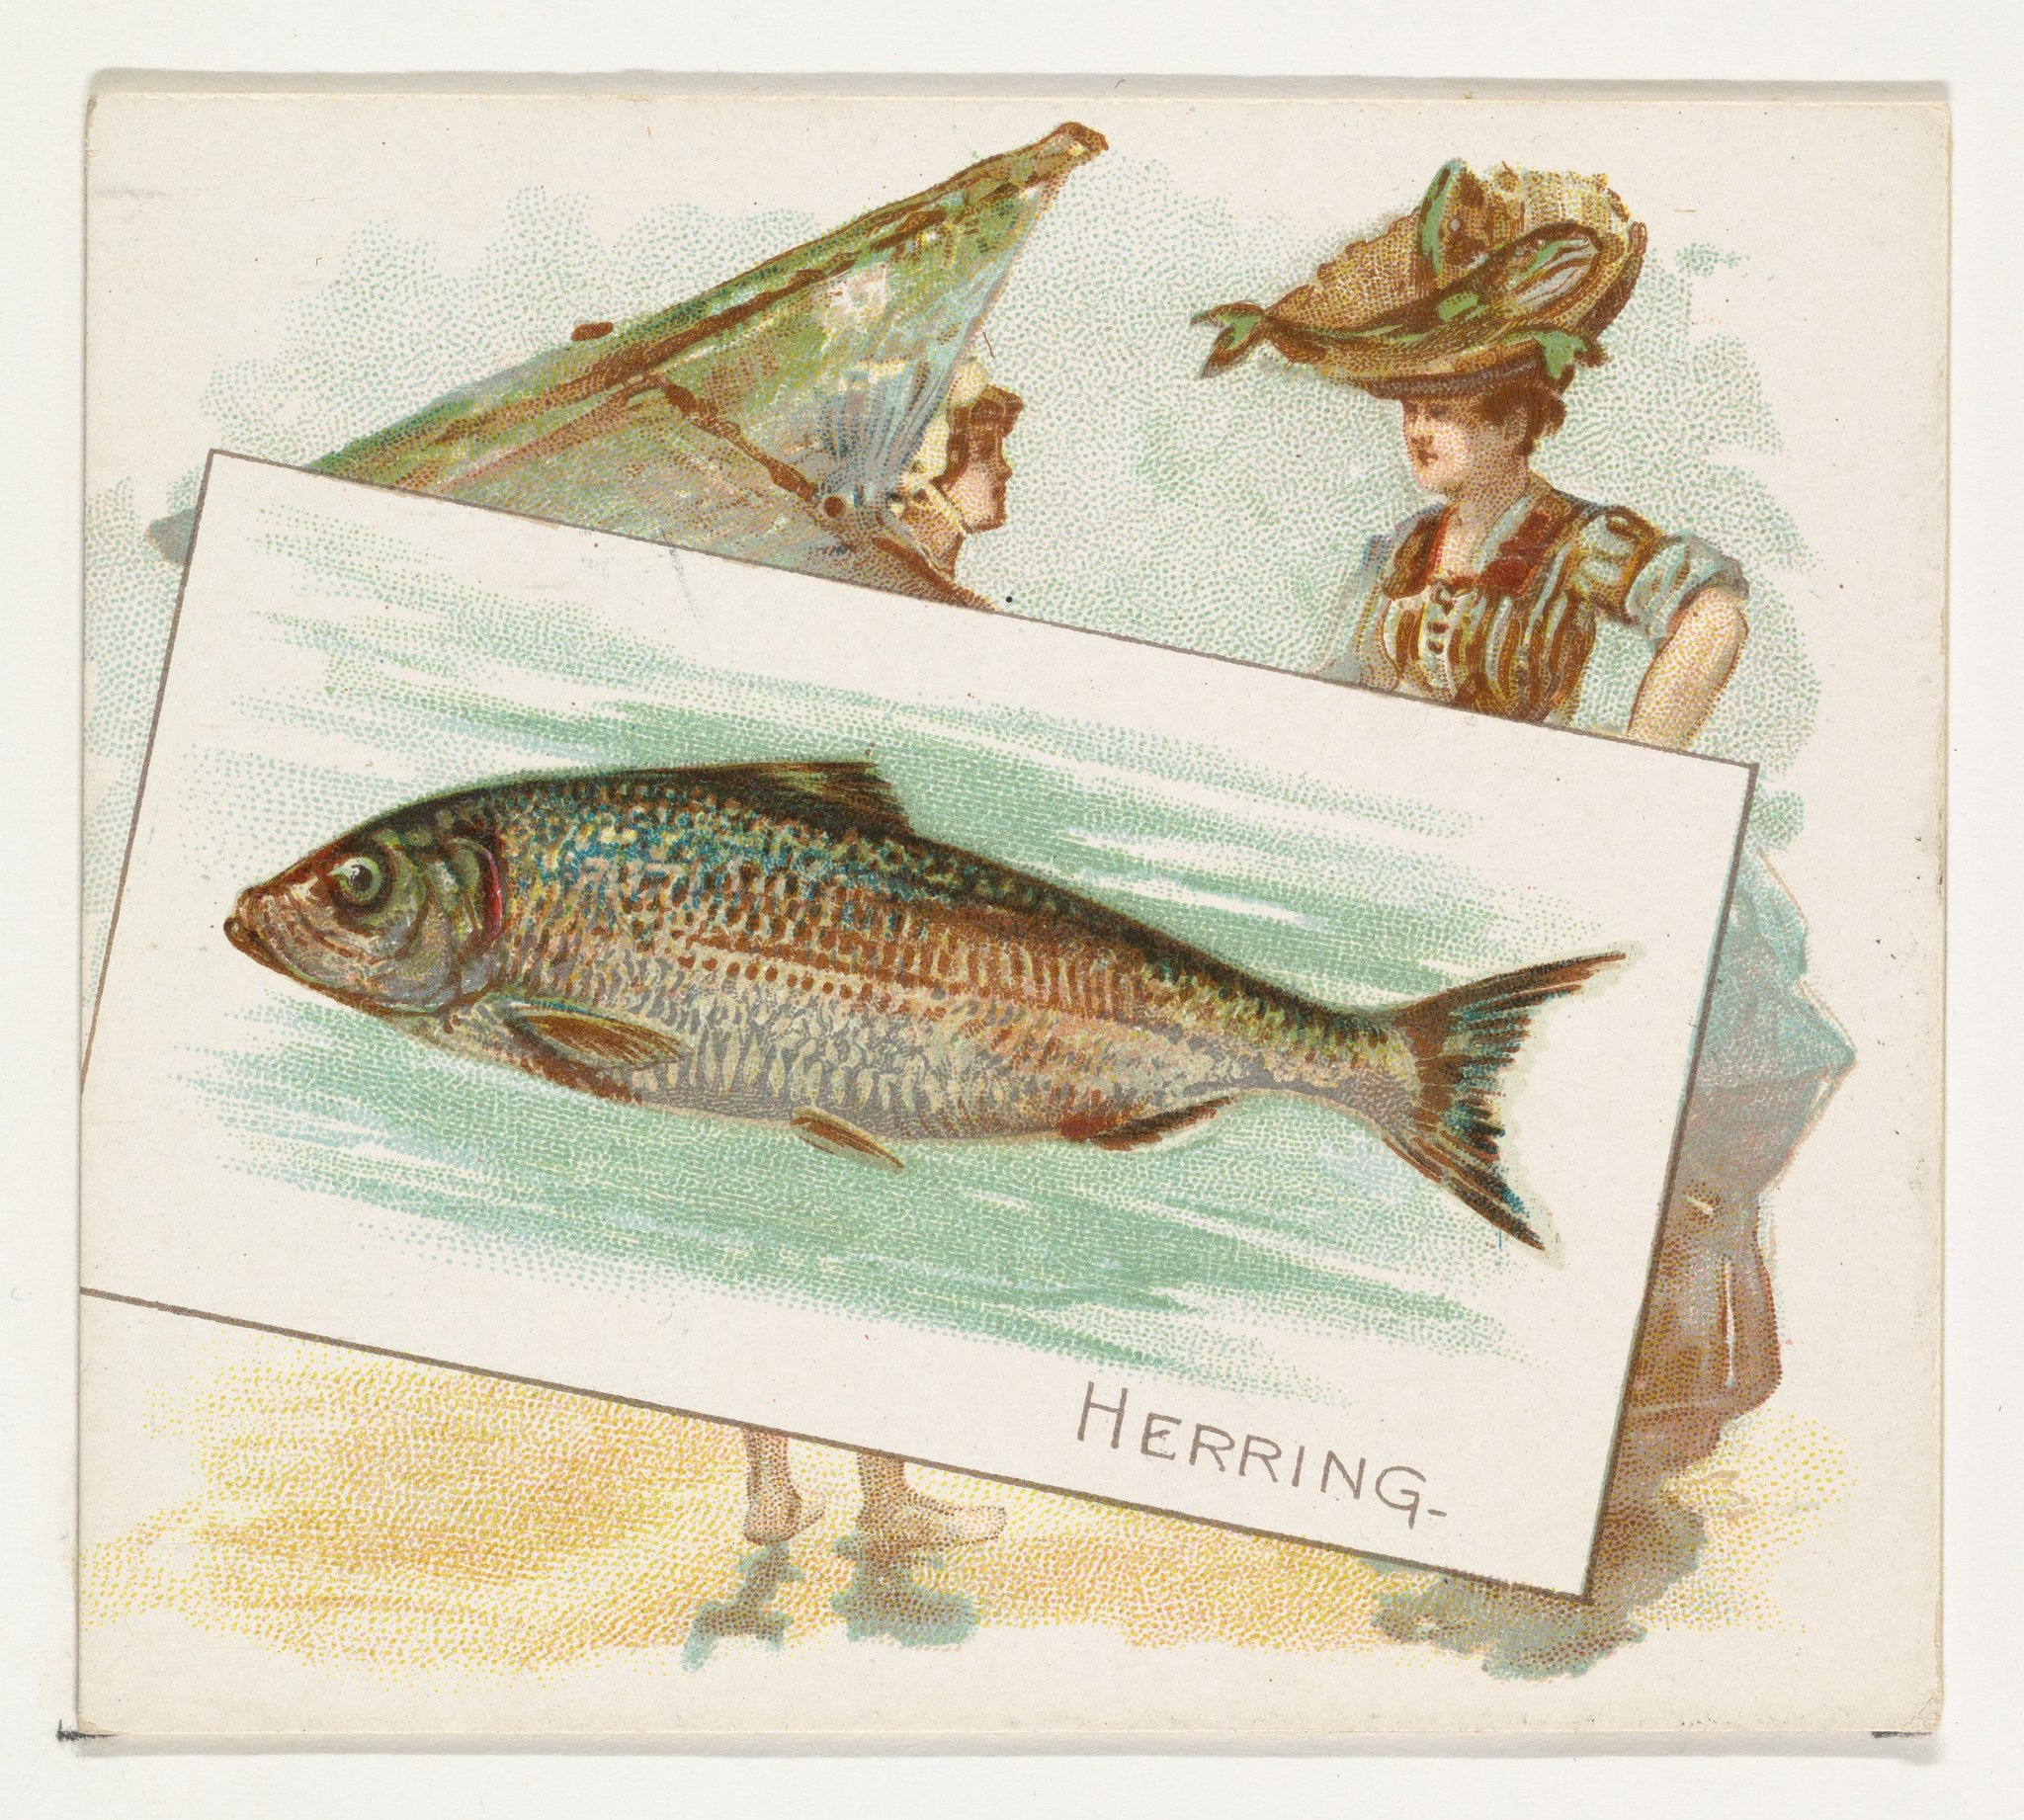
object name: print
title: Herring, from Fish from American Waters series (N39) for Allen & Ginter Cigarettes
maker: allen & ginter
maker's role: publisher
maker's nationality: american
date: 1889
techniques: color lithograph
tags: fish